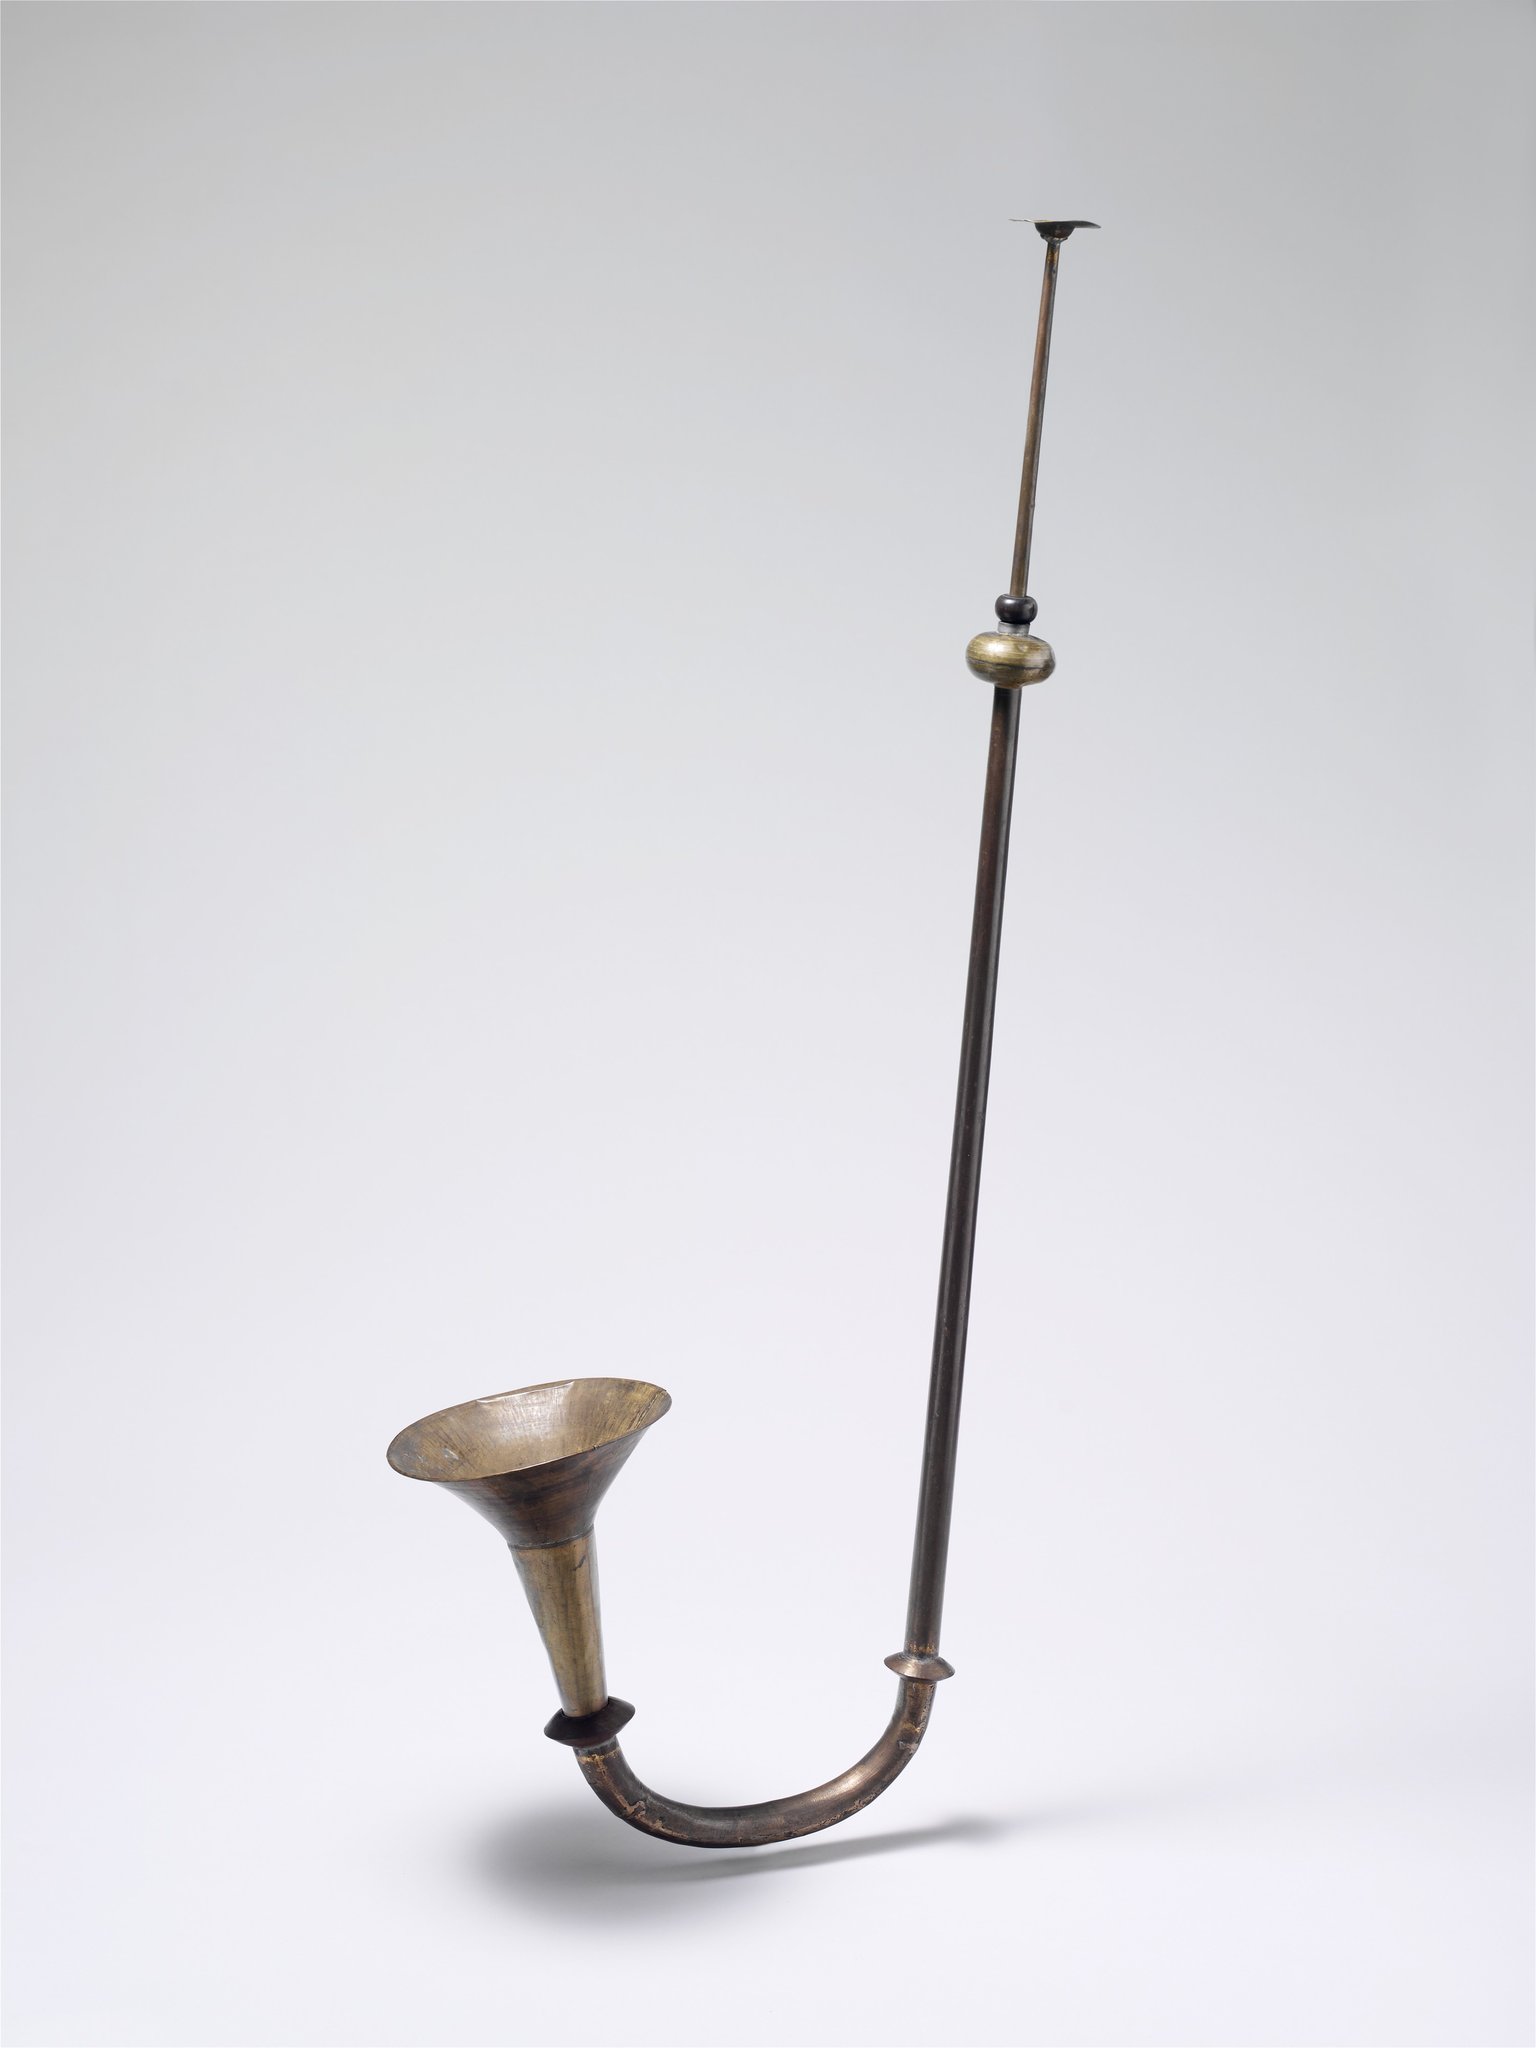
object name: zhajiao trumpet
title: Zhajiao (Trumpet)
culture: chinese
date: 1834-1900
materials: brass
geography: china